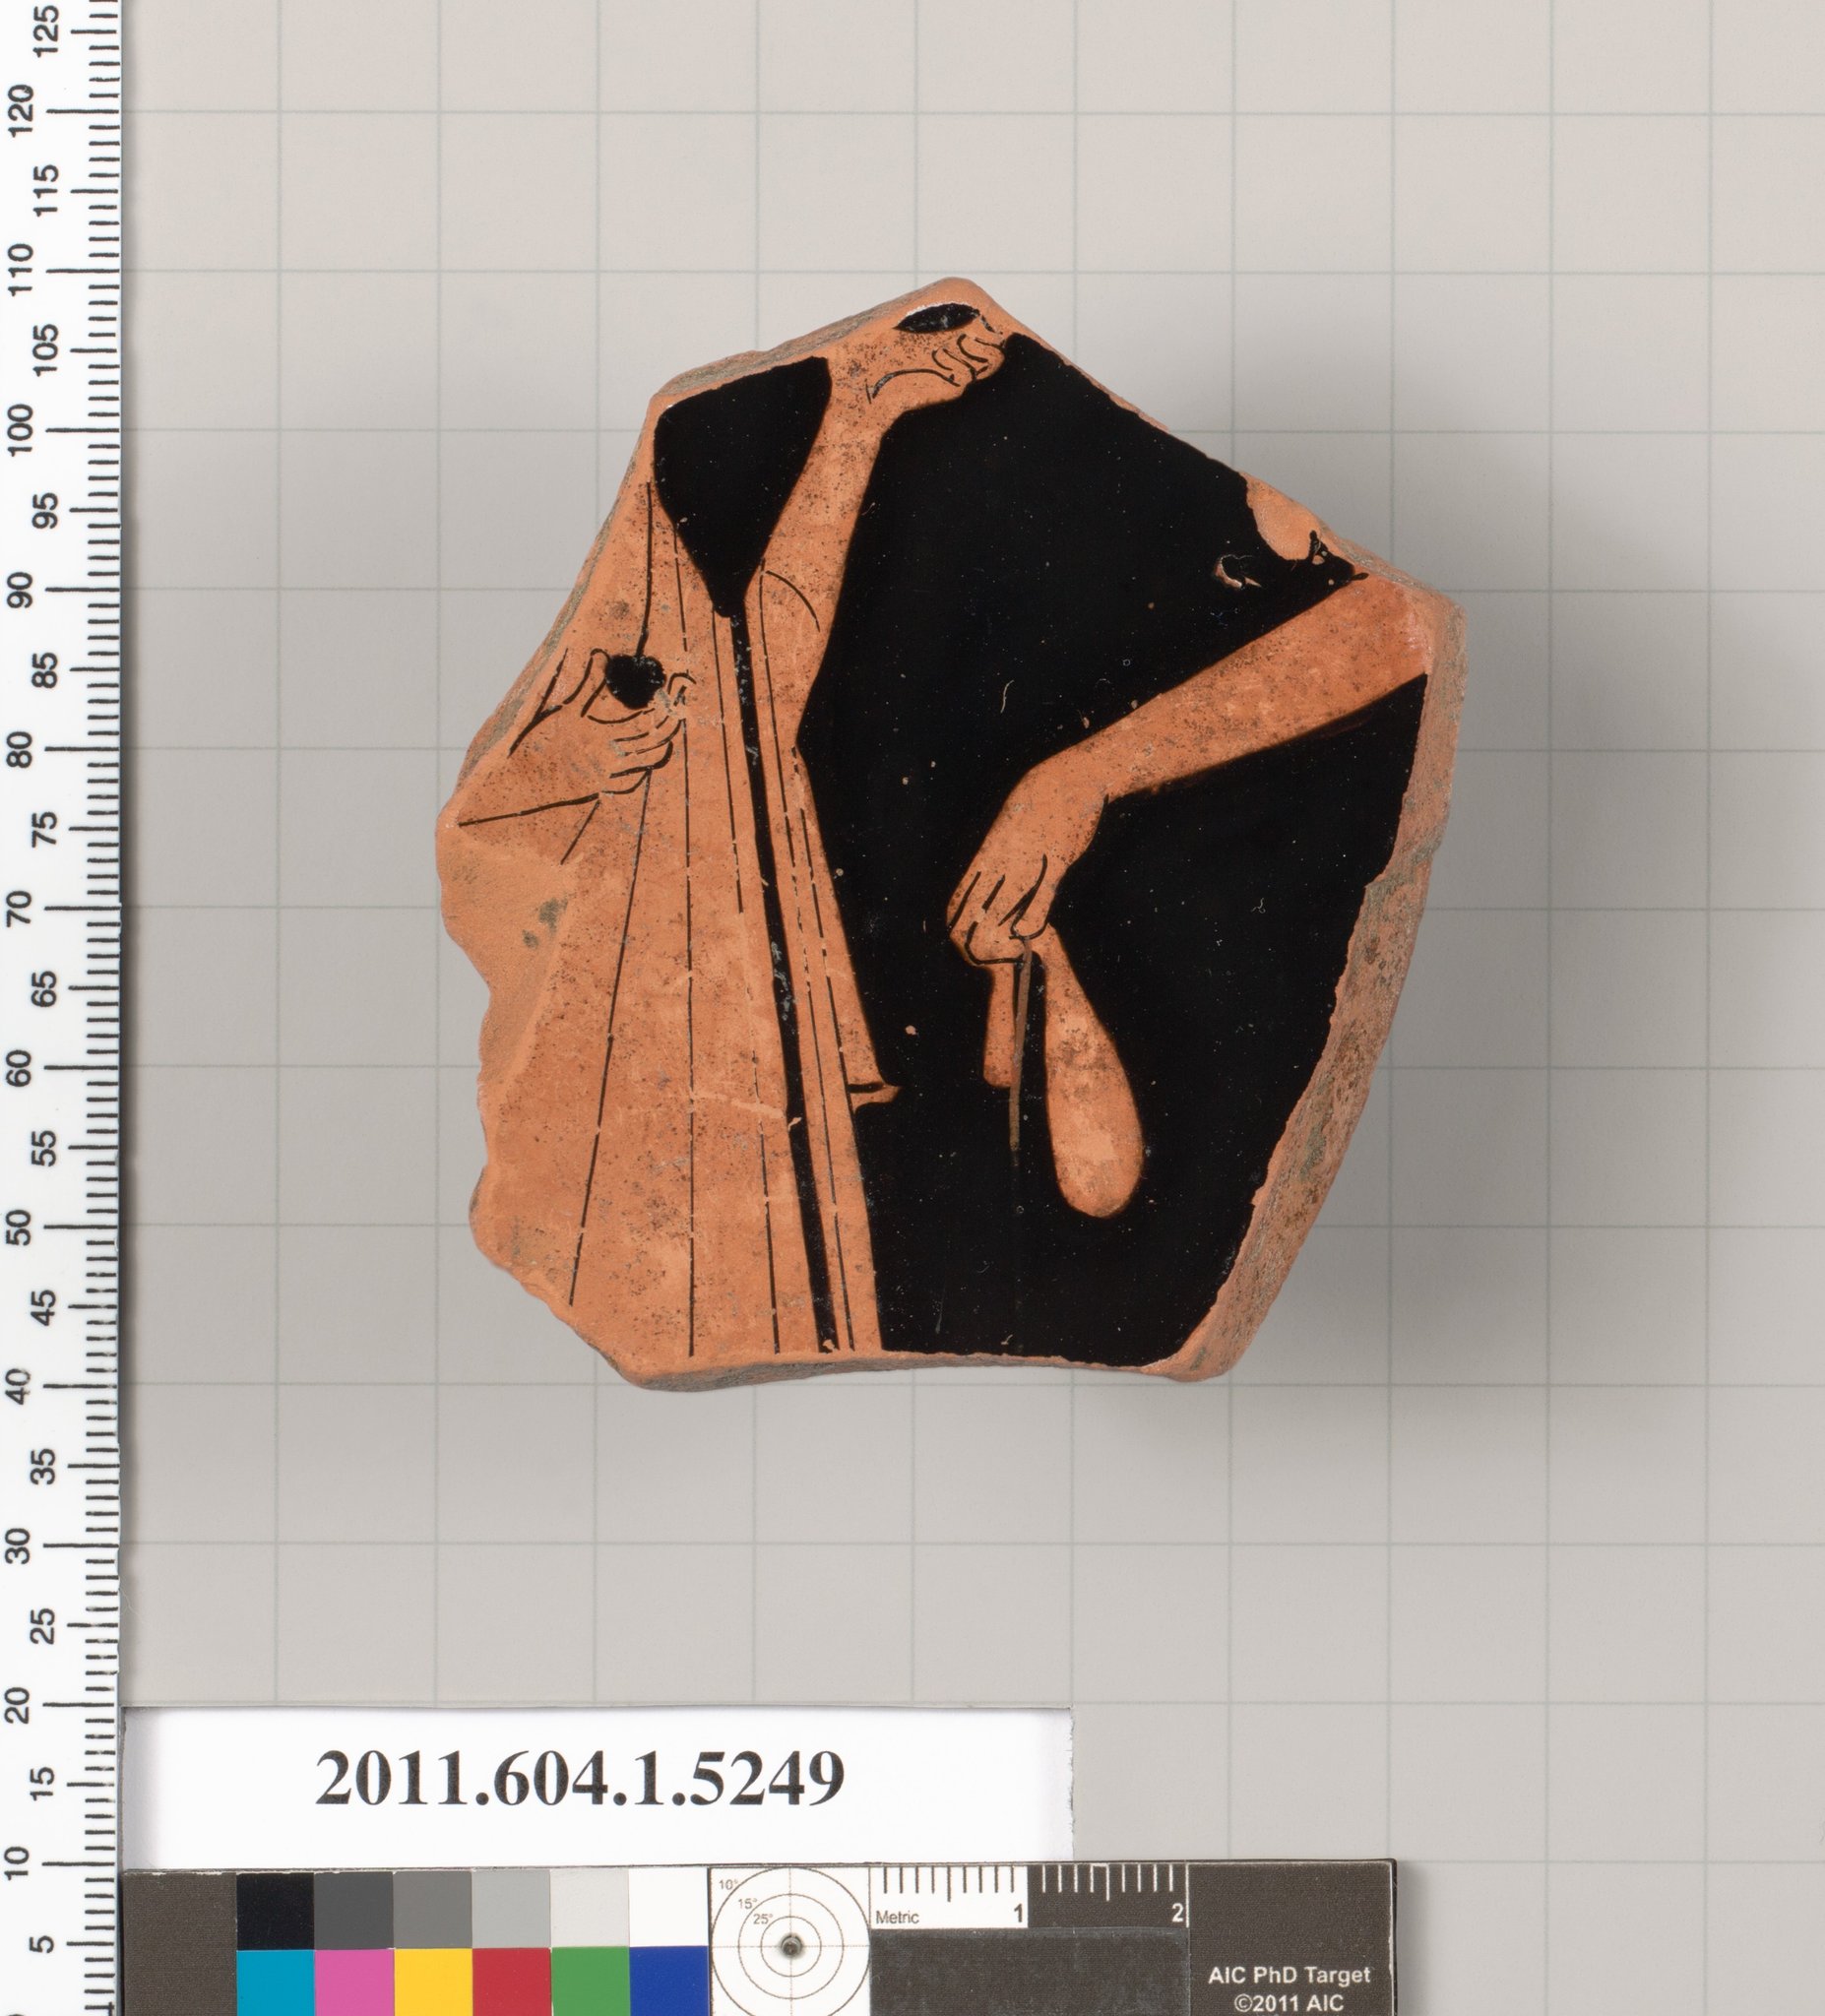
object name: kylix fragment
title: Terracotta fragment of a kylix (drinking cup)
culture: greek, attic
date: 475-451 BCE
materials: terracotta